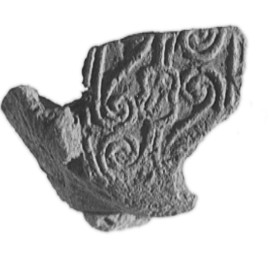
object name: sealing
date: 2030-1640 BCE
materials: clay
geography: egypt